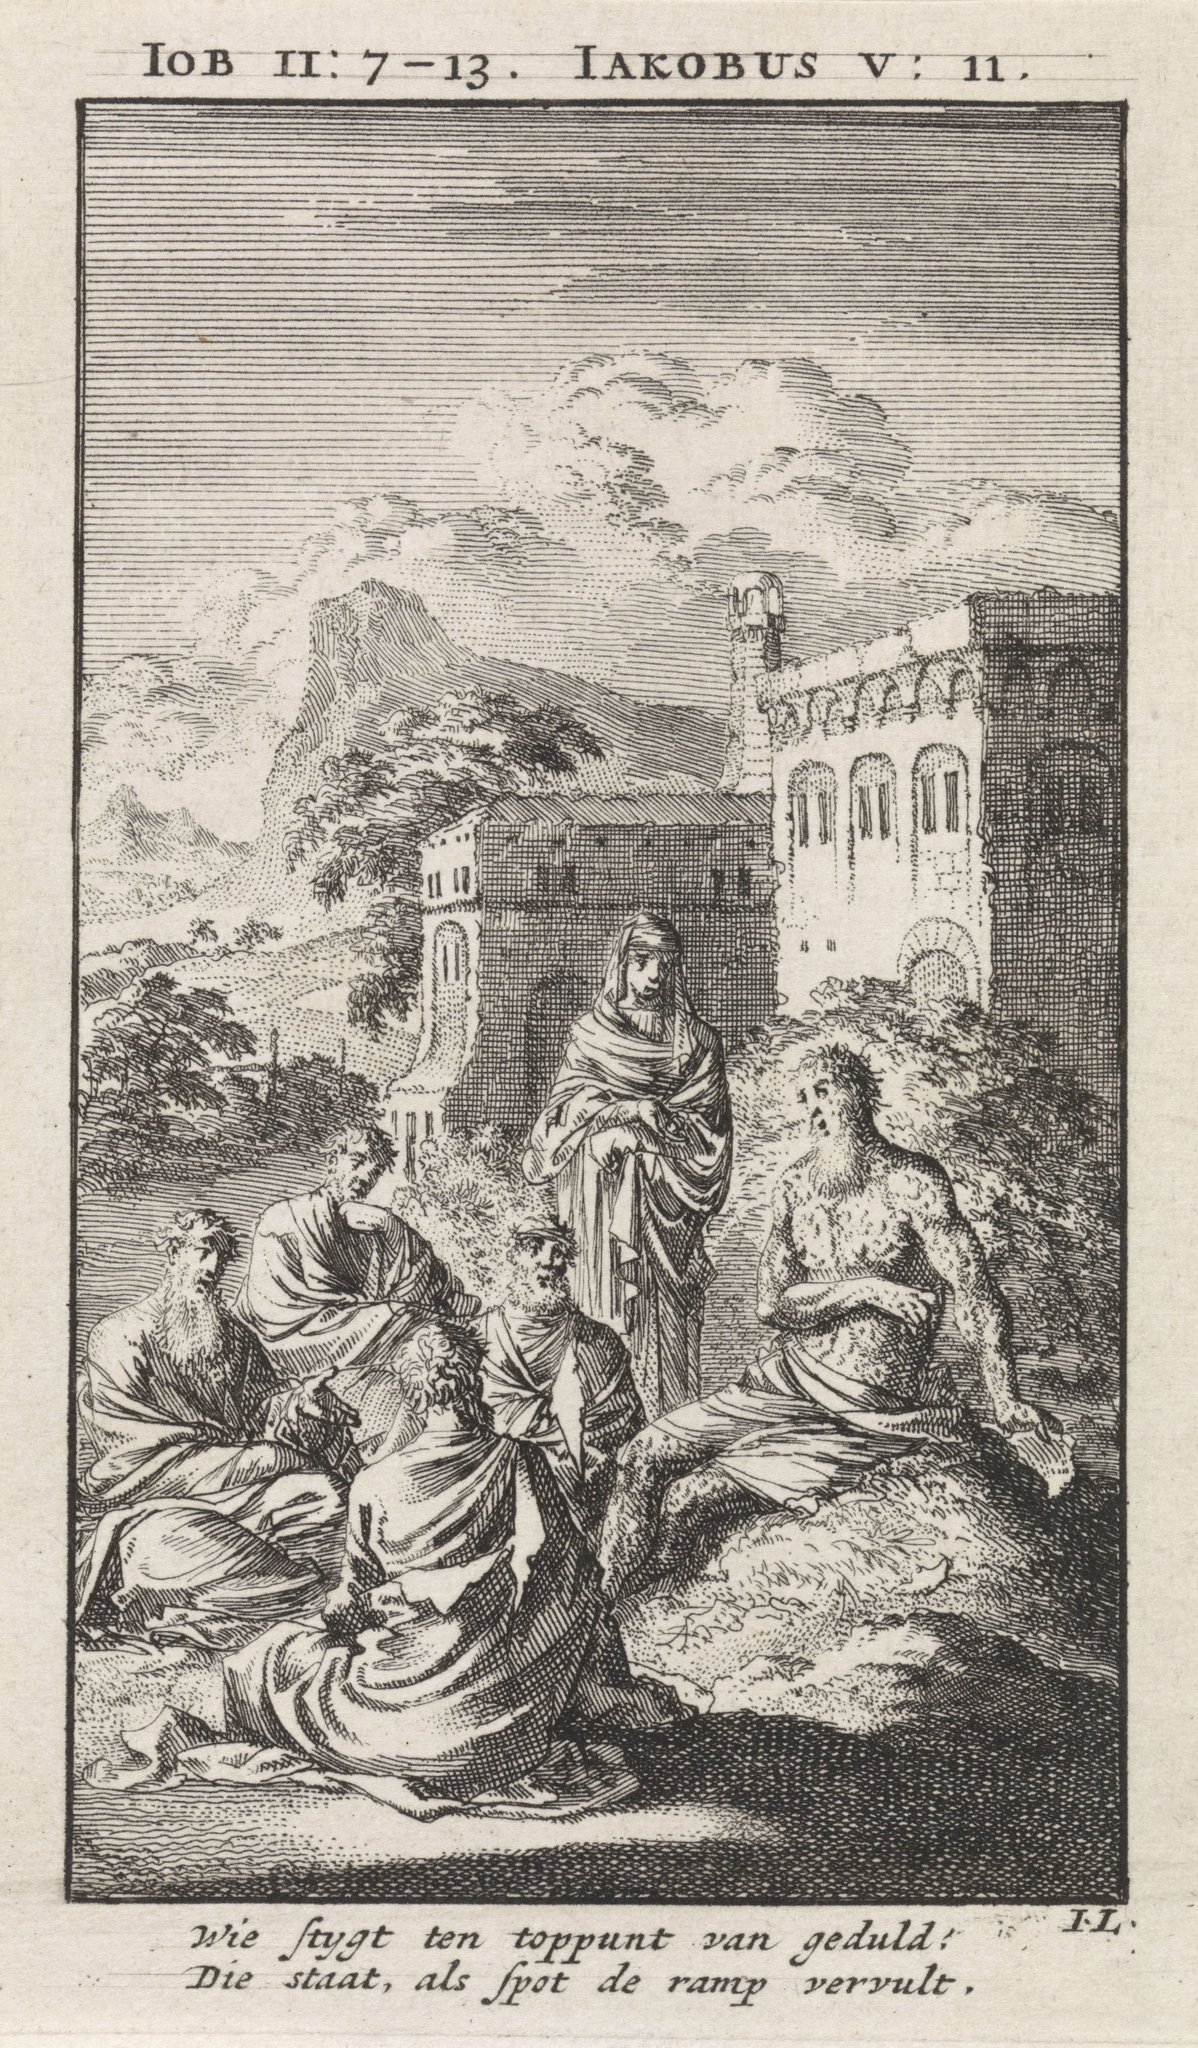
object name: print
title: Job op de mesthoop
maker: jan luyken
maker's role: draughtsman, print maker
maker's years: 1649-1712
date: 1712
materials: paper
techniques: etching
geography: amsterdam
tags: job on the dunghill (job 2:7-13)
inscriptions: collector's mark: Lugt 2228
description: Illustratie voor: Luyken, Jan. Bybel printen. Amsterdam: Pieter Arentsz. II (wed.) en Cornelis van der Sys, 1712, p. 13.